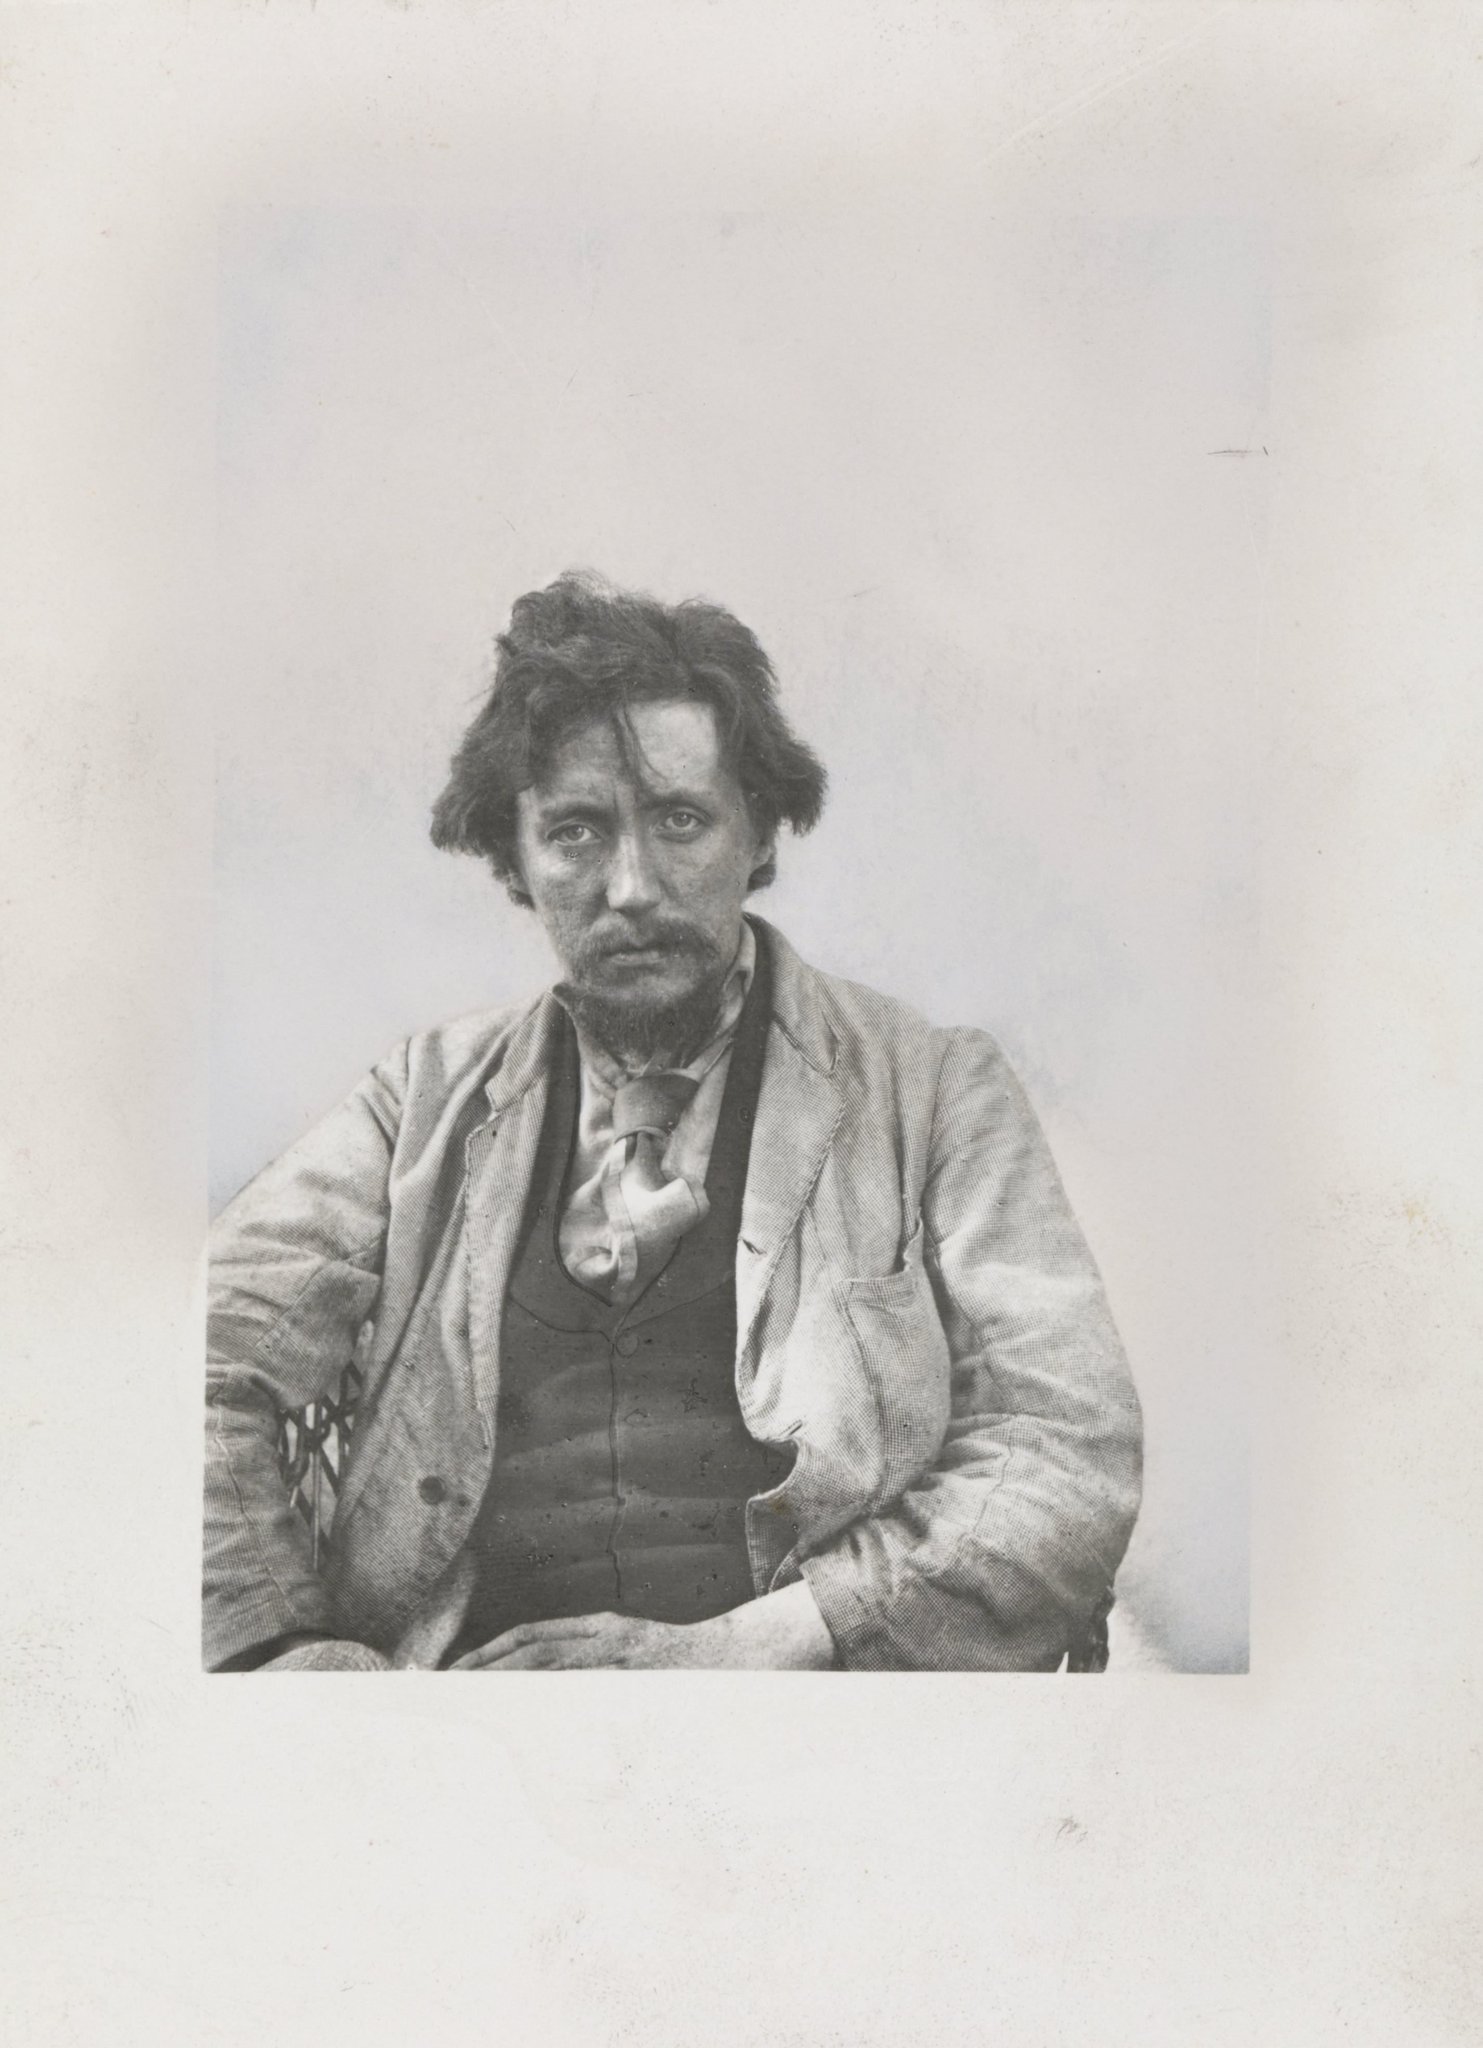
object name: photograph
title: Reproductie naar een foto, schilderij, tekening of prent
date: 1860-1915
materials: paper, photographic support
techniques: gelatin silver print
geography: netherlands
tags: amsterdam, the hague, willem kloos